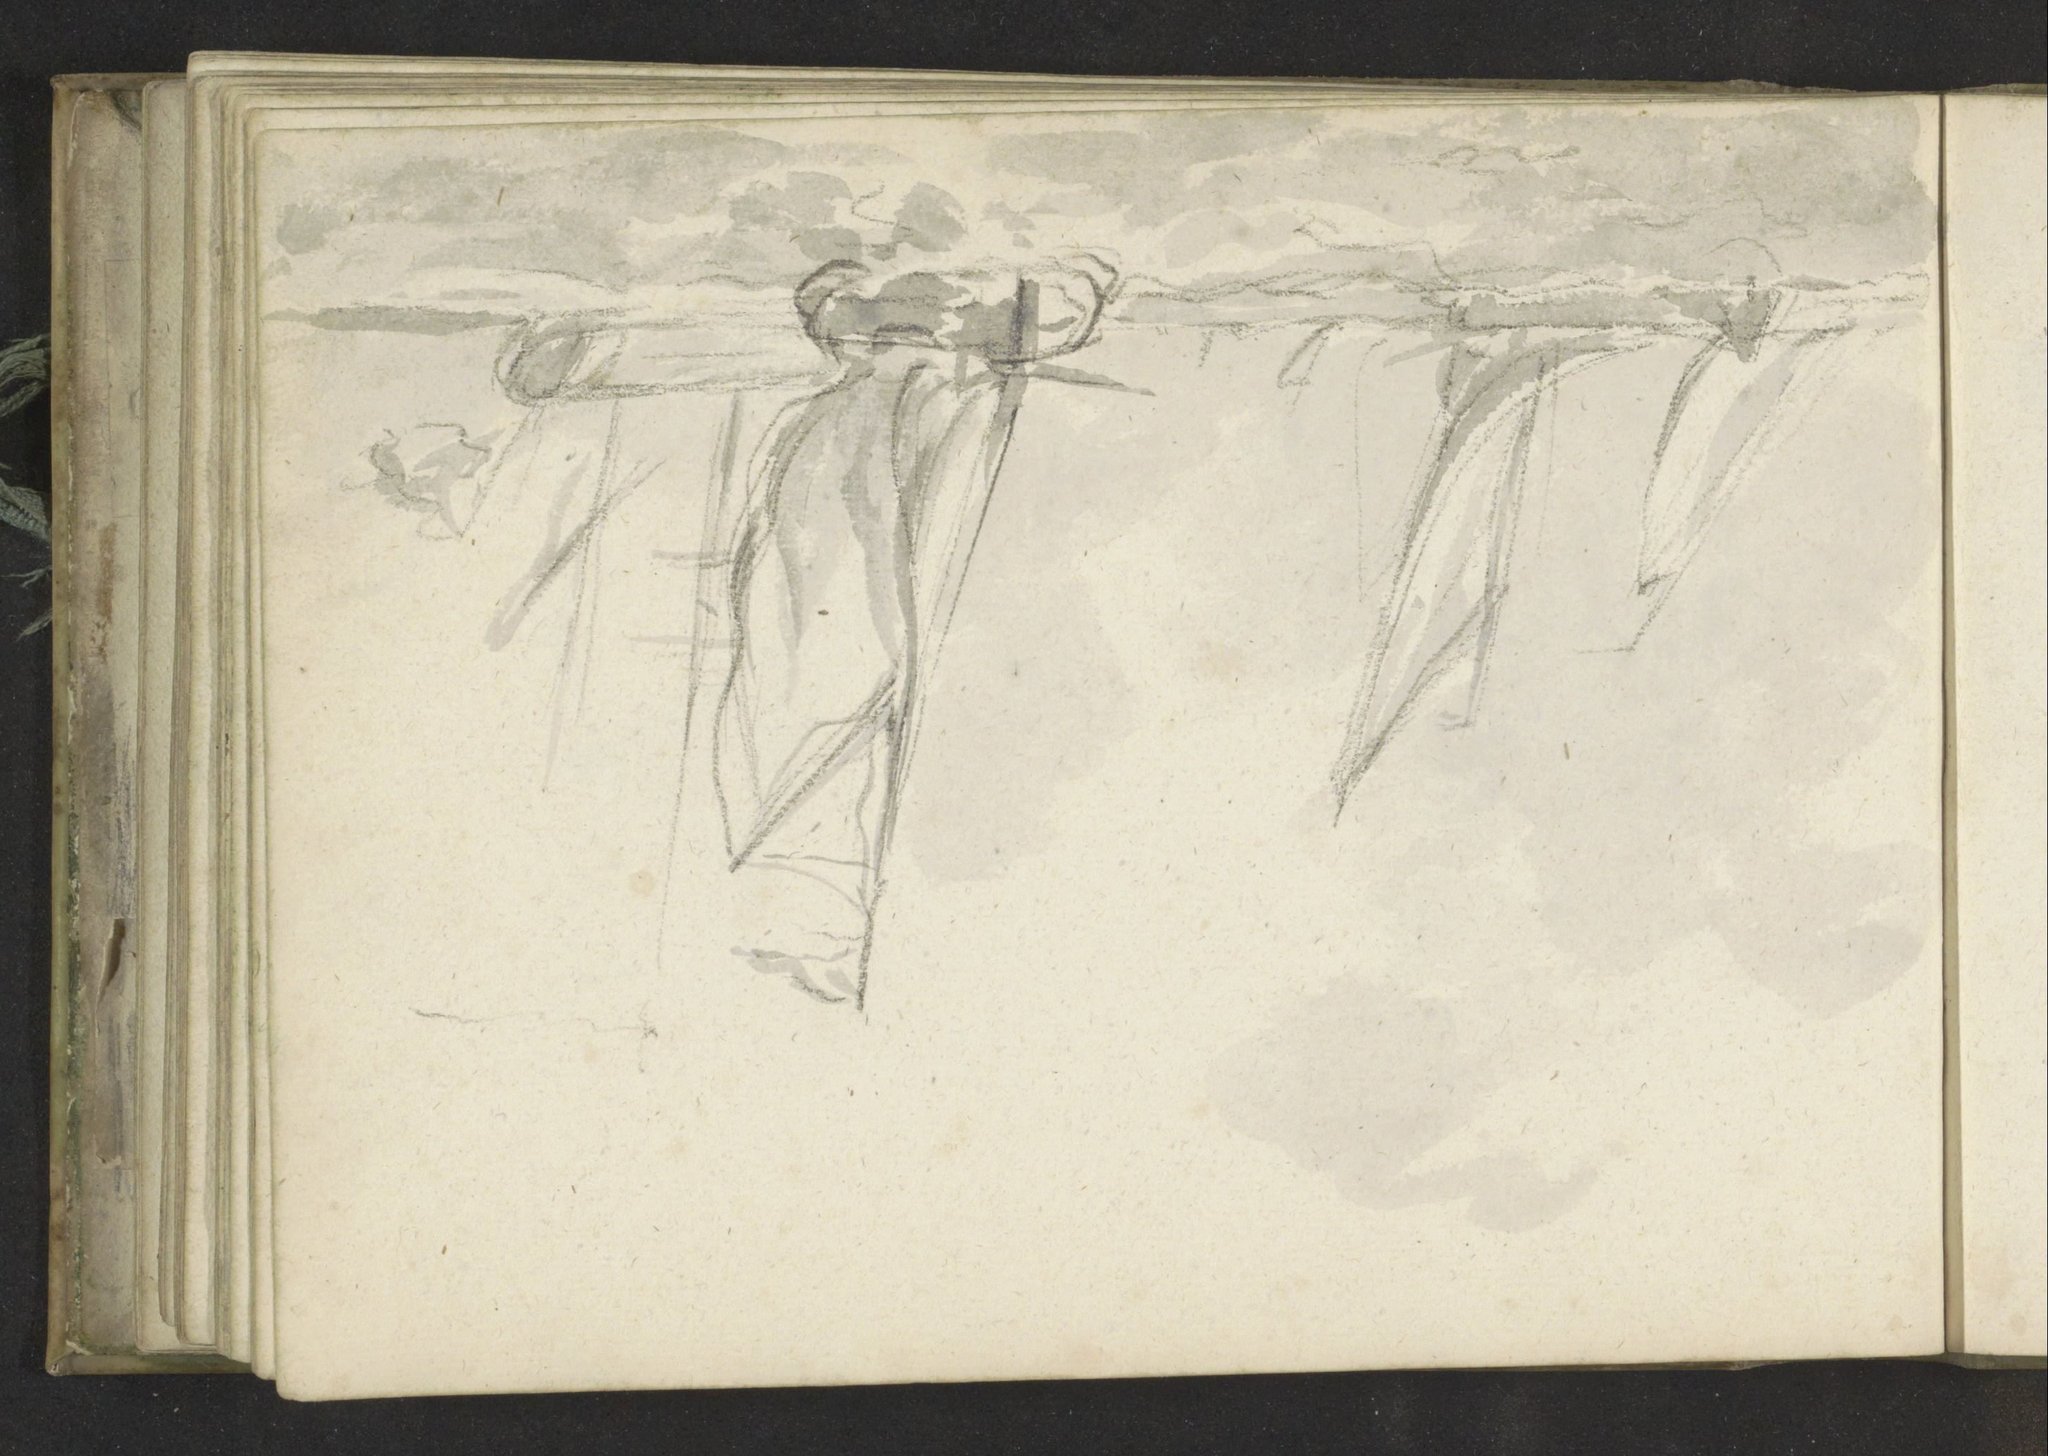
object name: sketchbook leaf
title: Zeilschepen op het water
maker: martinus schouman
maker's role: draughtsman, painter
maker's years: 1770-1848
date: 1780-1848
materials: chalk, paper, watercolor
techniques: brush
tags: sailing-ship, sailing-boat, landscapes with waters, waterscapes, seascapes (in the temperate zone)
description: Blad 45 verso uit een schetsboek met 53 bladen.